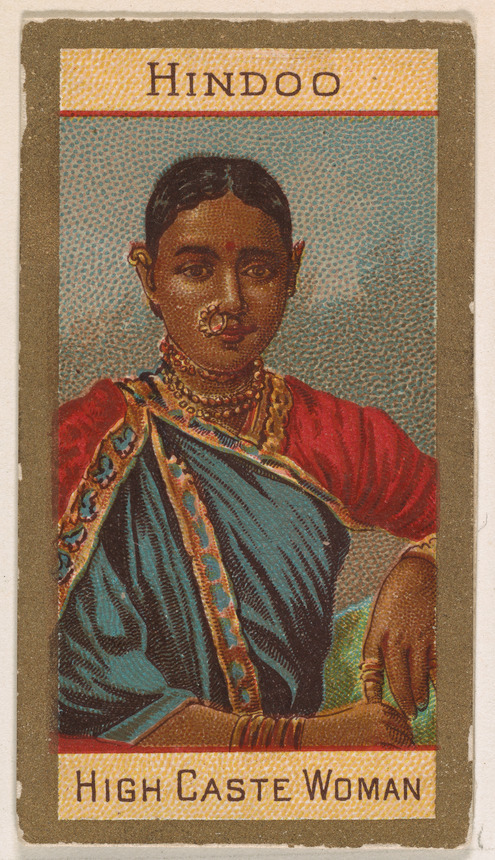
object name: print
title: Hindoo, High Caste Woman, from Types of Nationalities (N240) issued by Kinney Bros.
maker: kinney brothers tobacco company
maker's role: publisher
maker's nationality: american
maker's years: 1869-2011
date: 1890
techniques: color lithograph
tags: women